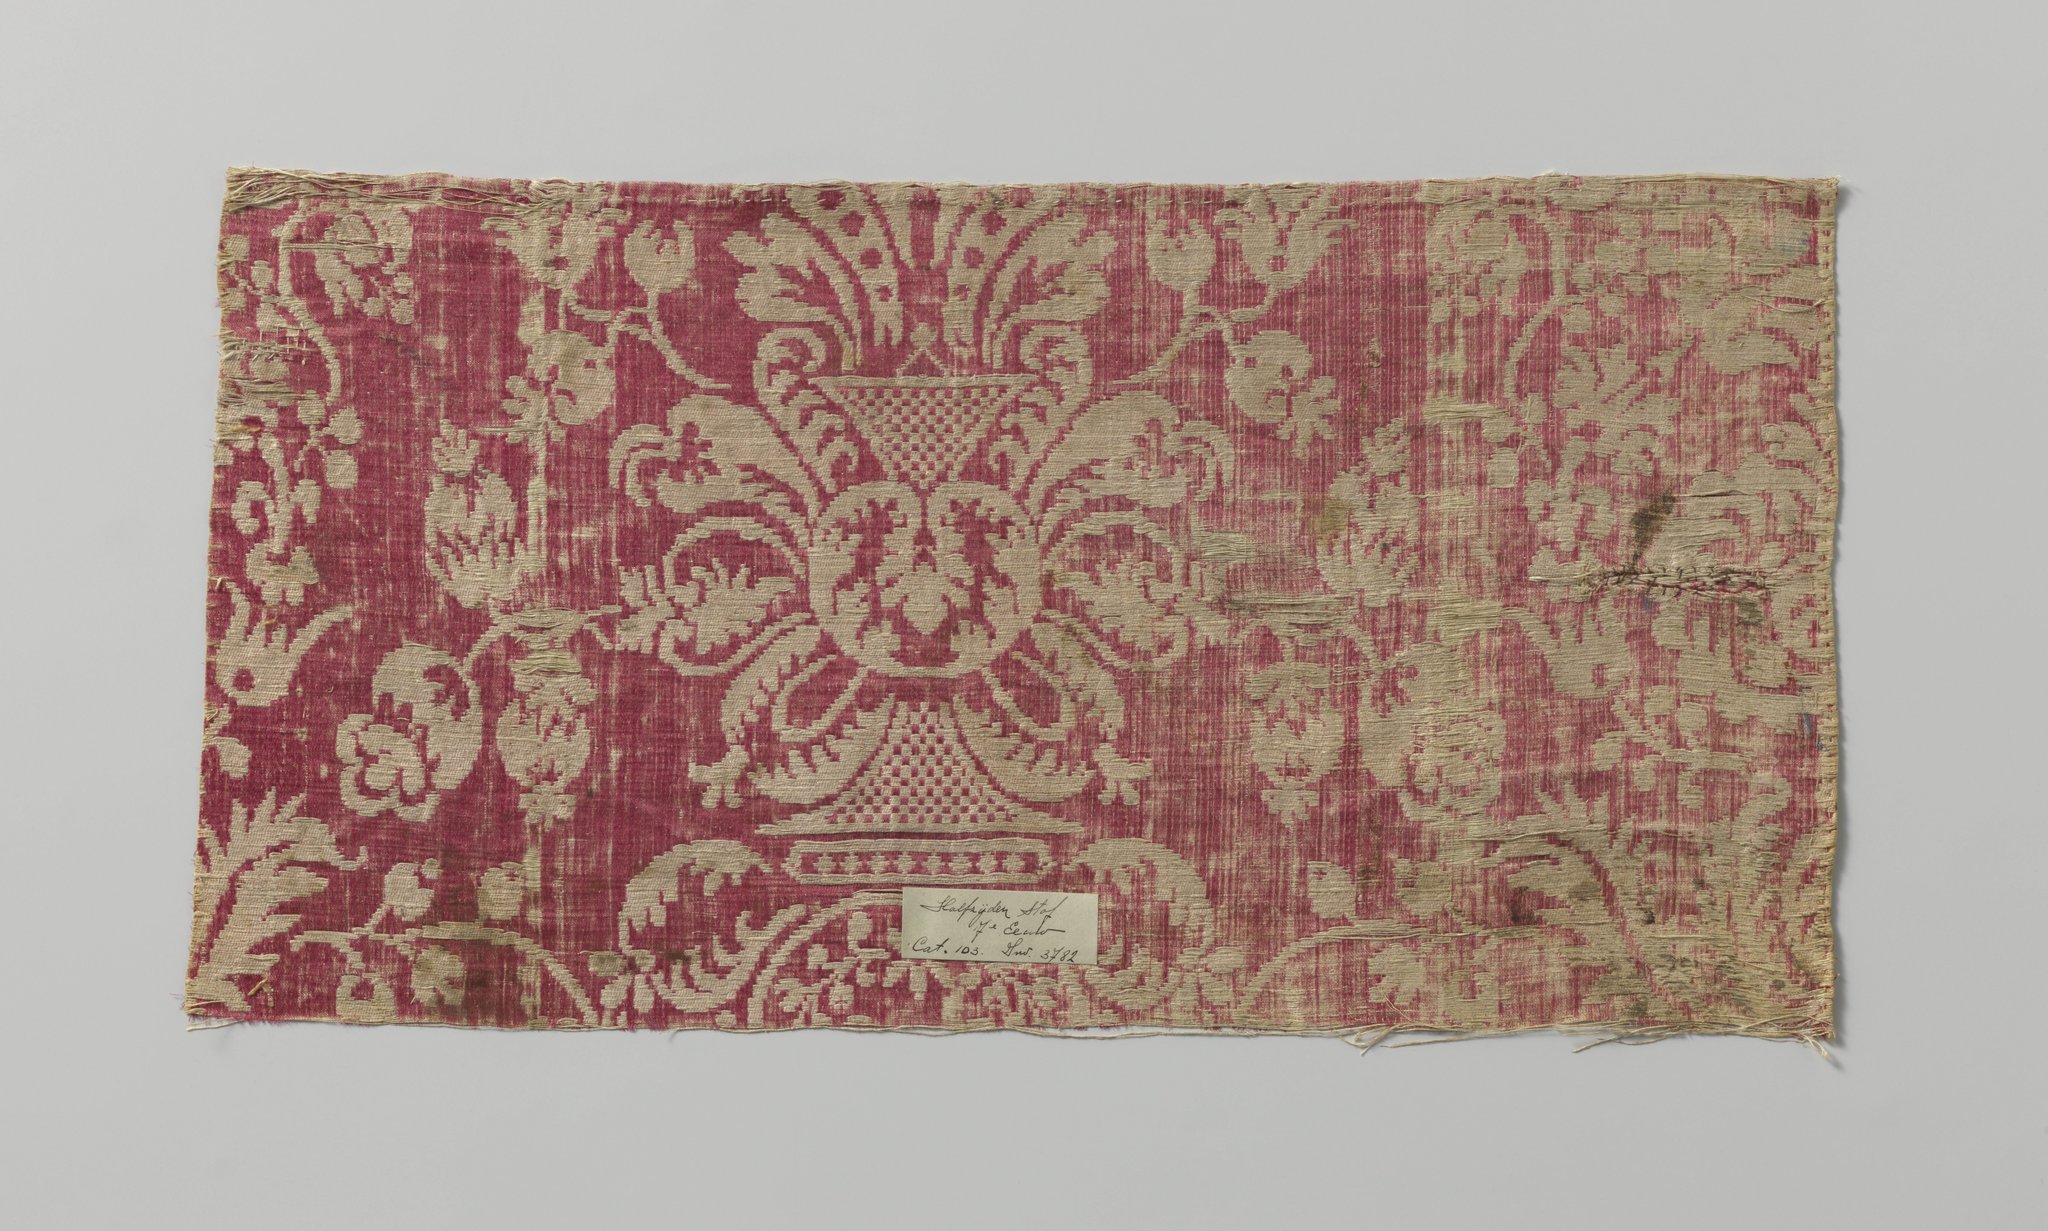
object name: zijdedamast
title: Fragment van twee aan elkaar gezette stukken rode zijde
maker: Anonymous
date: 1690-1710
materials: linen, silk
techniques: damask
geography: germany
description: Fragment van twee aan elkaar gezette stukken rode zijde met patroon van vaasvorm met granaatappels (?) omgeven door weelderige bloem- en bladranken.